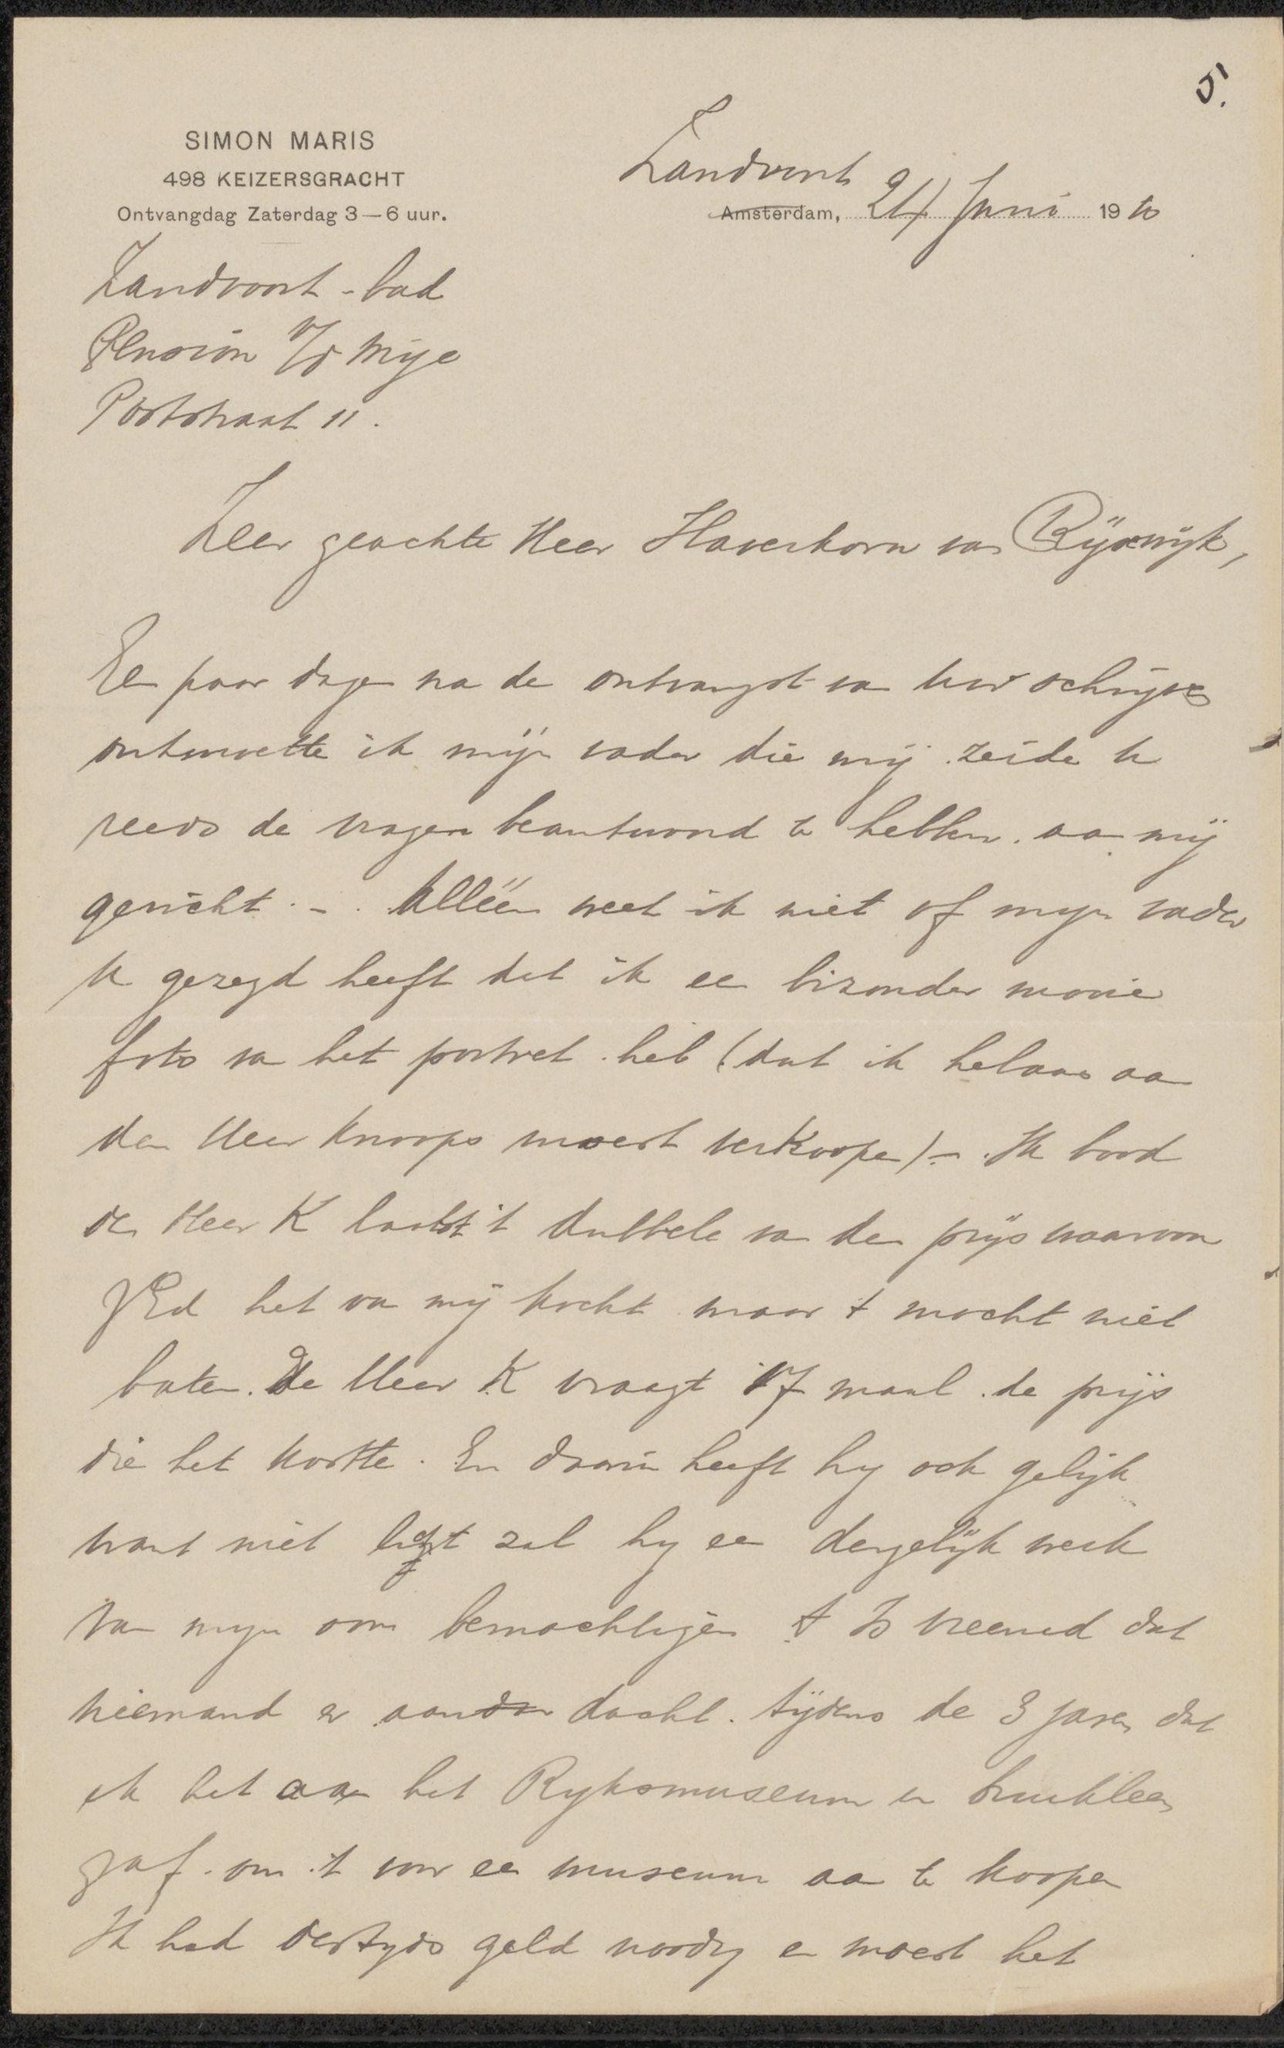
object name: letter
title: Brief aan Pieter Haverkorn van Rijsewijk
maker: simon maris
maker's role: painter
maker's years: 1873-1935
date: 1910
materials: ink, paper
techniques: pen, printing, writing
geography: zandvoort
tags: the hague, painter, willem maris, pieter haverkorn van rijsewijk, rijksmuseum amsterdam, art trade, art shop, historical persons (portraits and scenes from the life), money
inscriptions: watermark